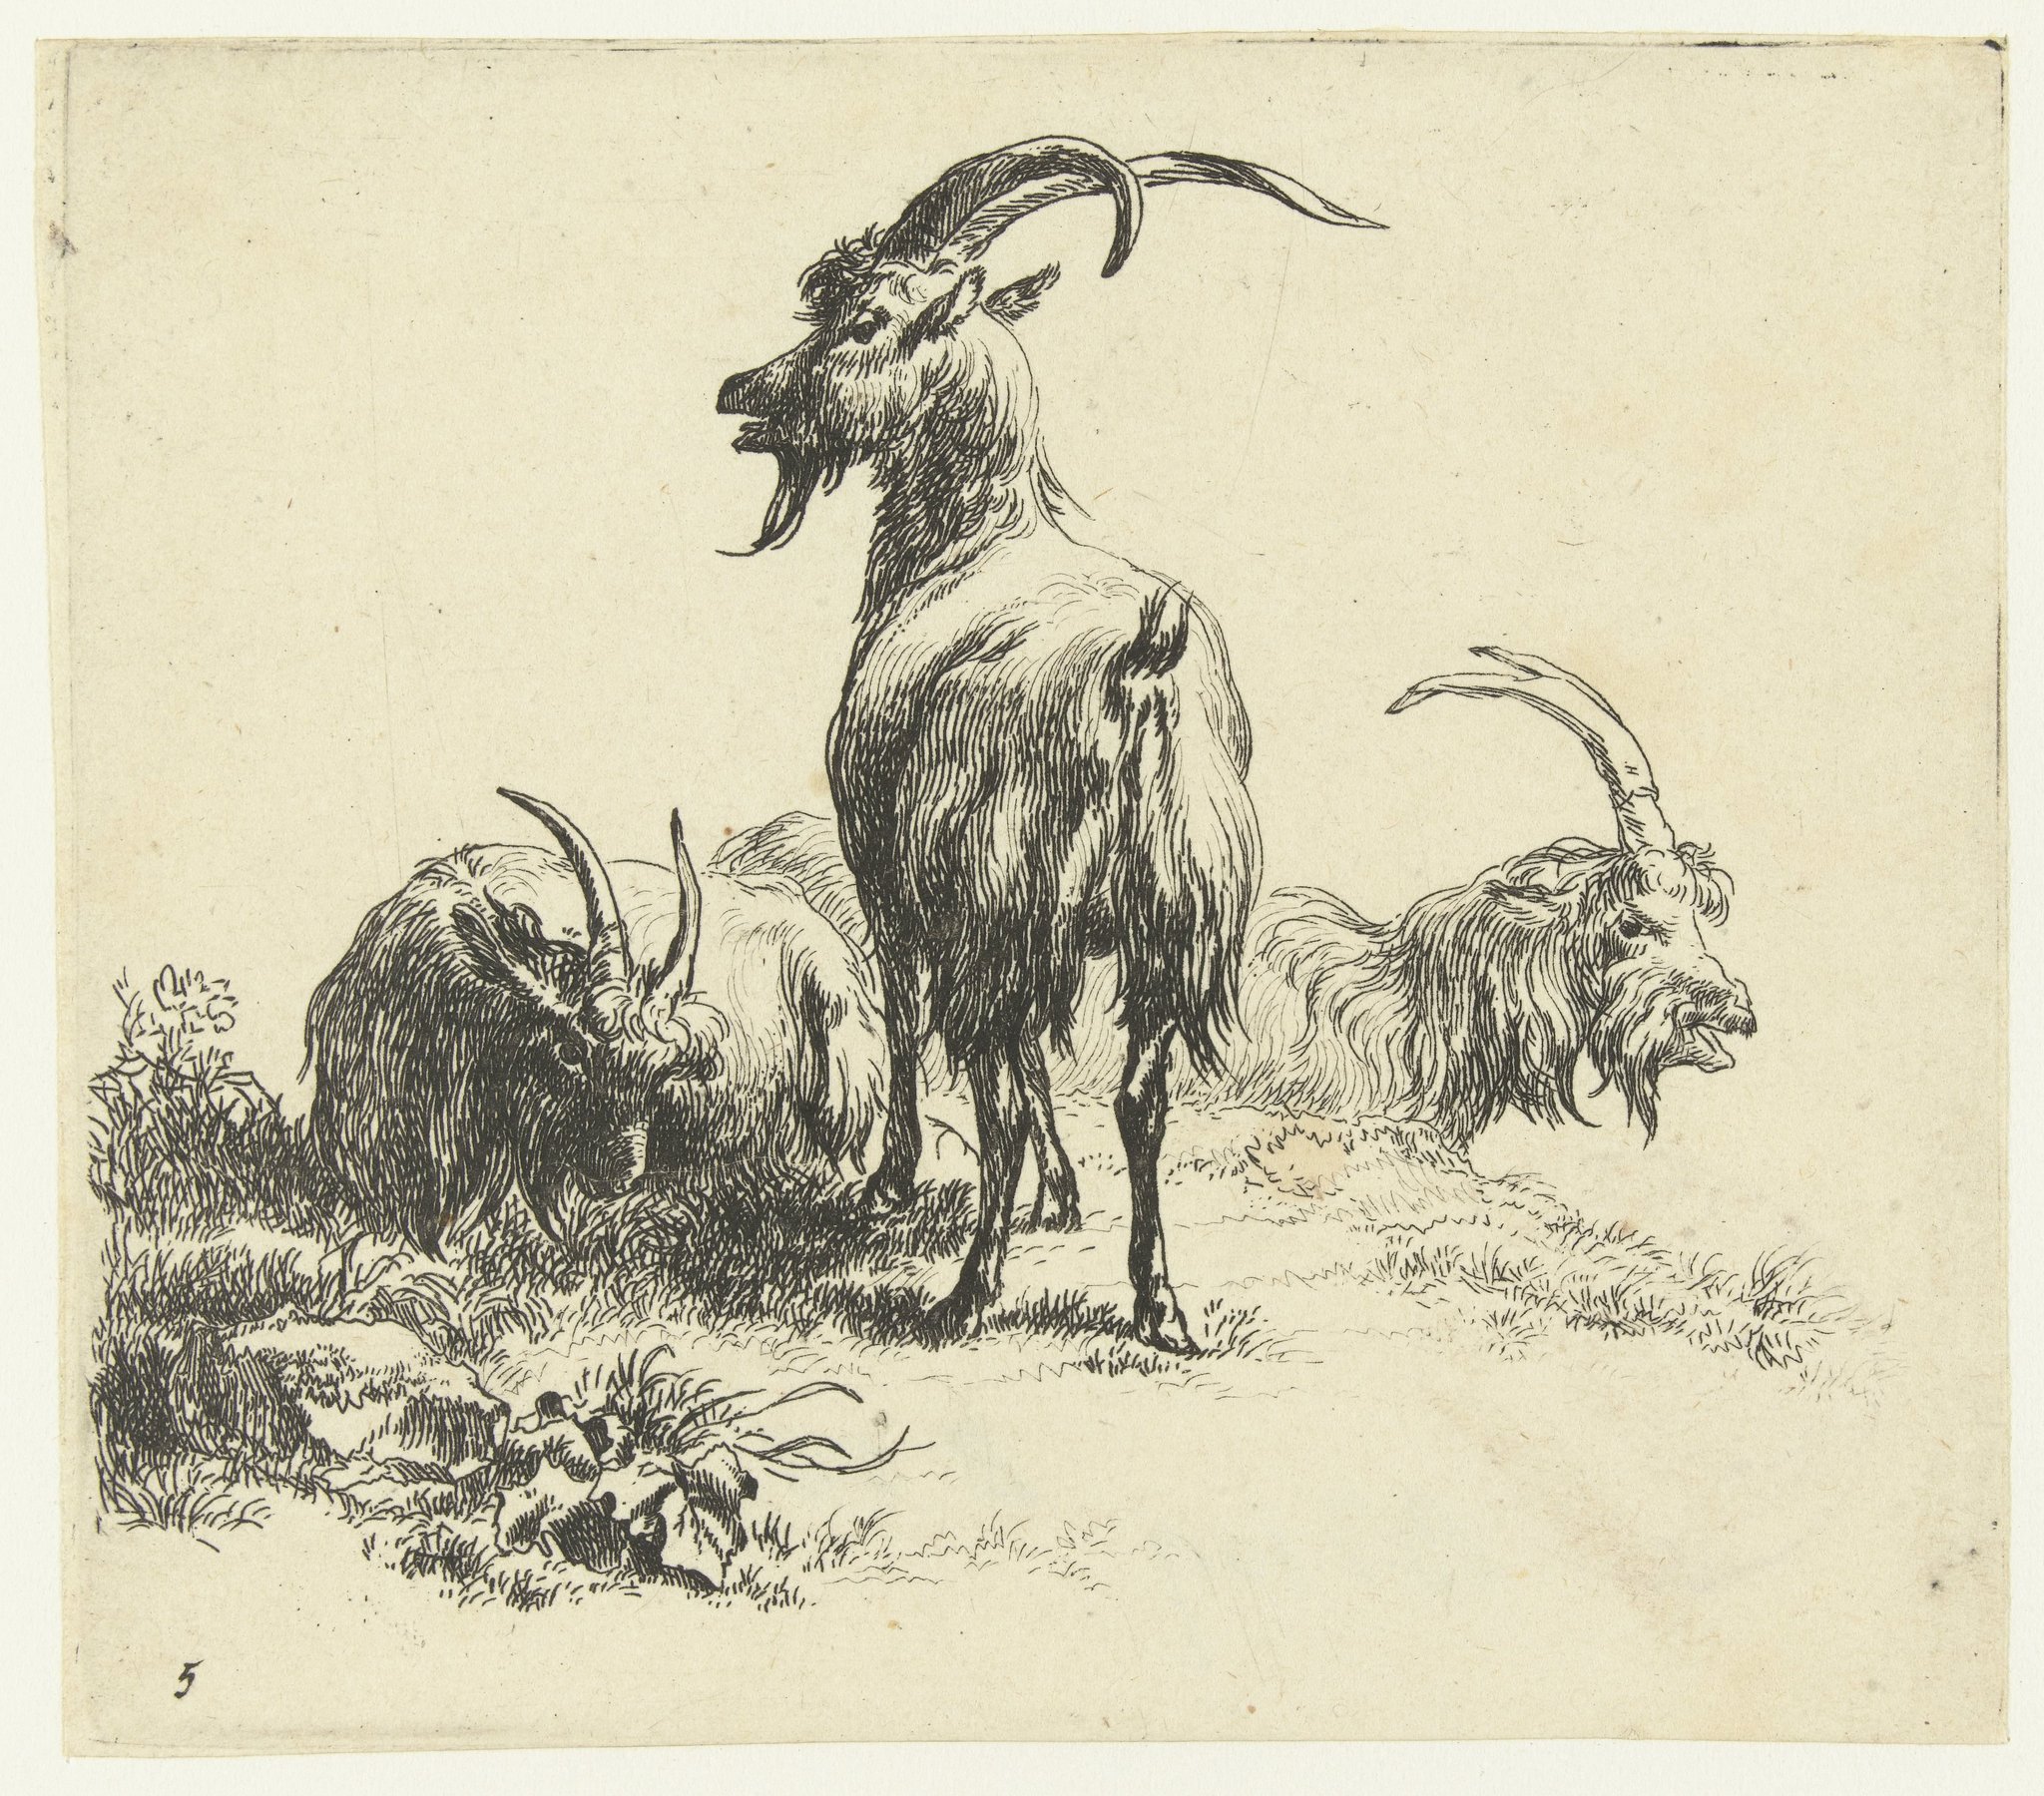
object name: print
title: Animalia ad vivum delineata et aqua forti aeri impressa Studio et Arte Nicolai Berchemi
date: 1648-1652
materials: paper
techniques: etching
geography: netherlands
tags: goat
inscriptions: collector's mark: Lugt 240